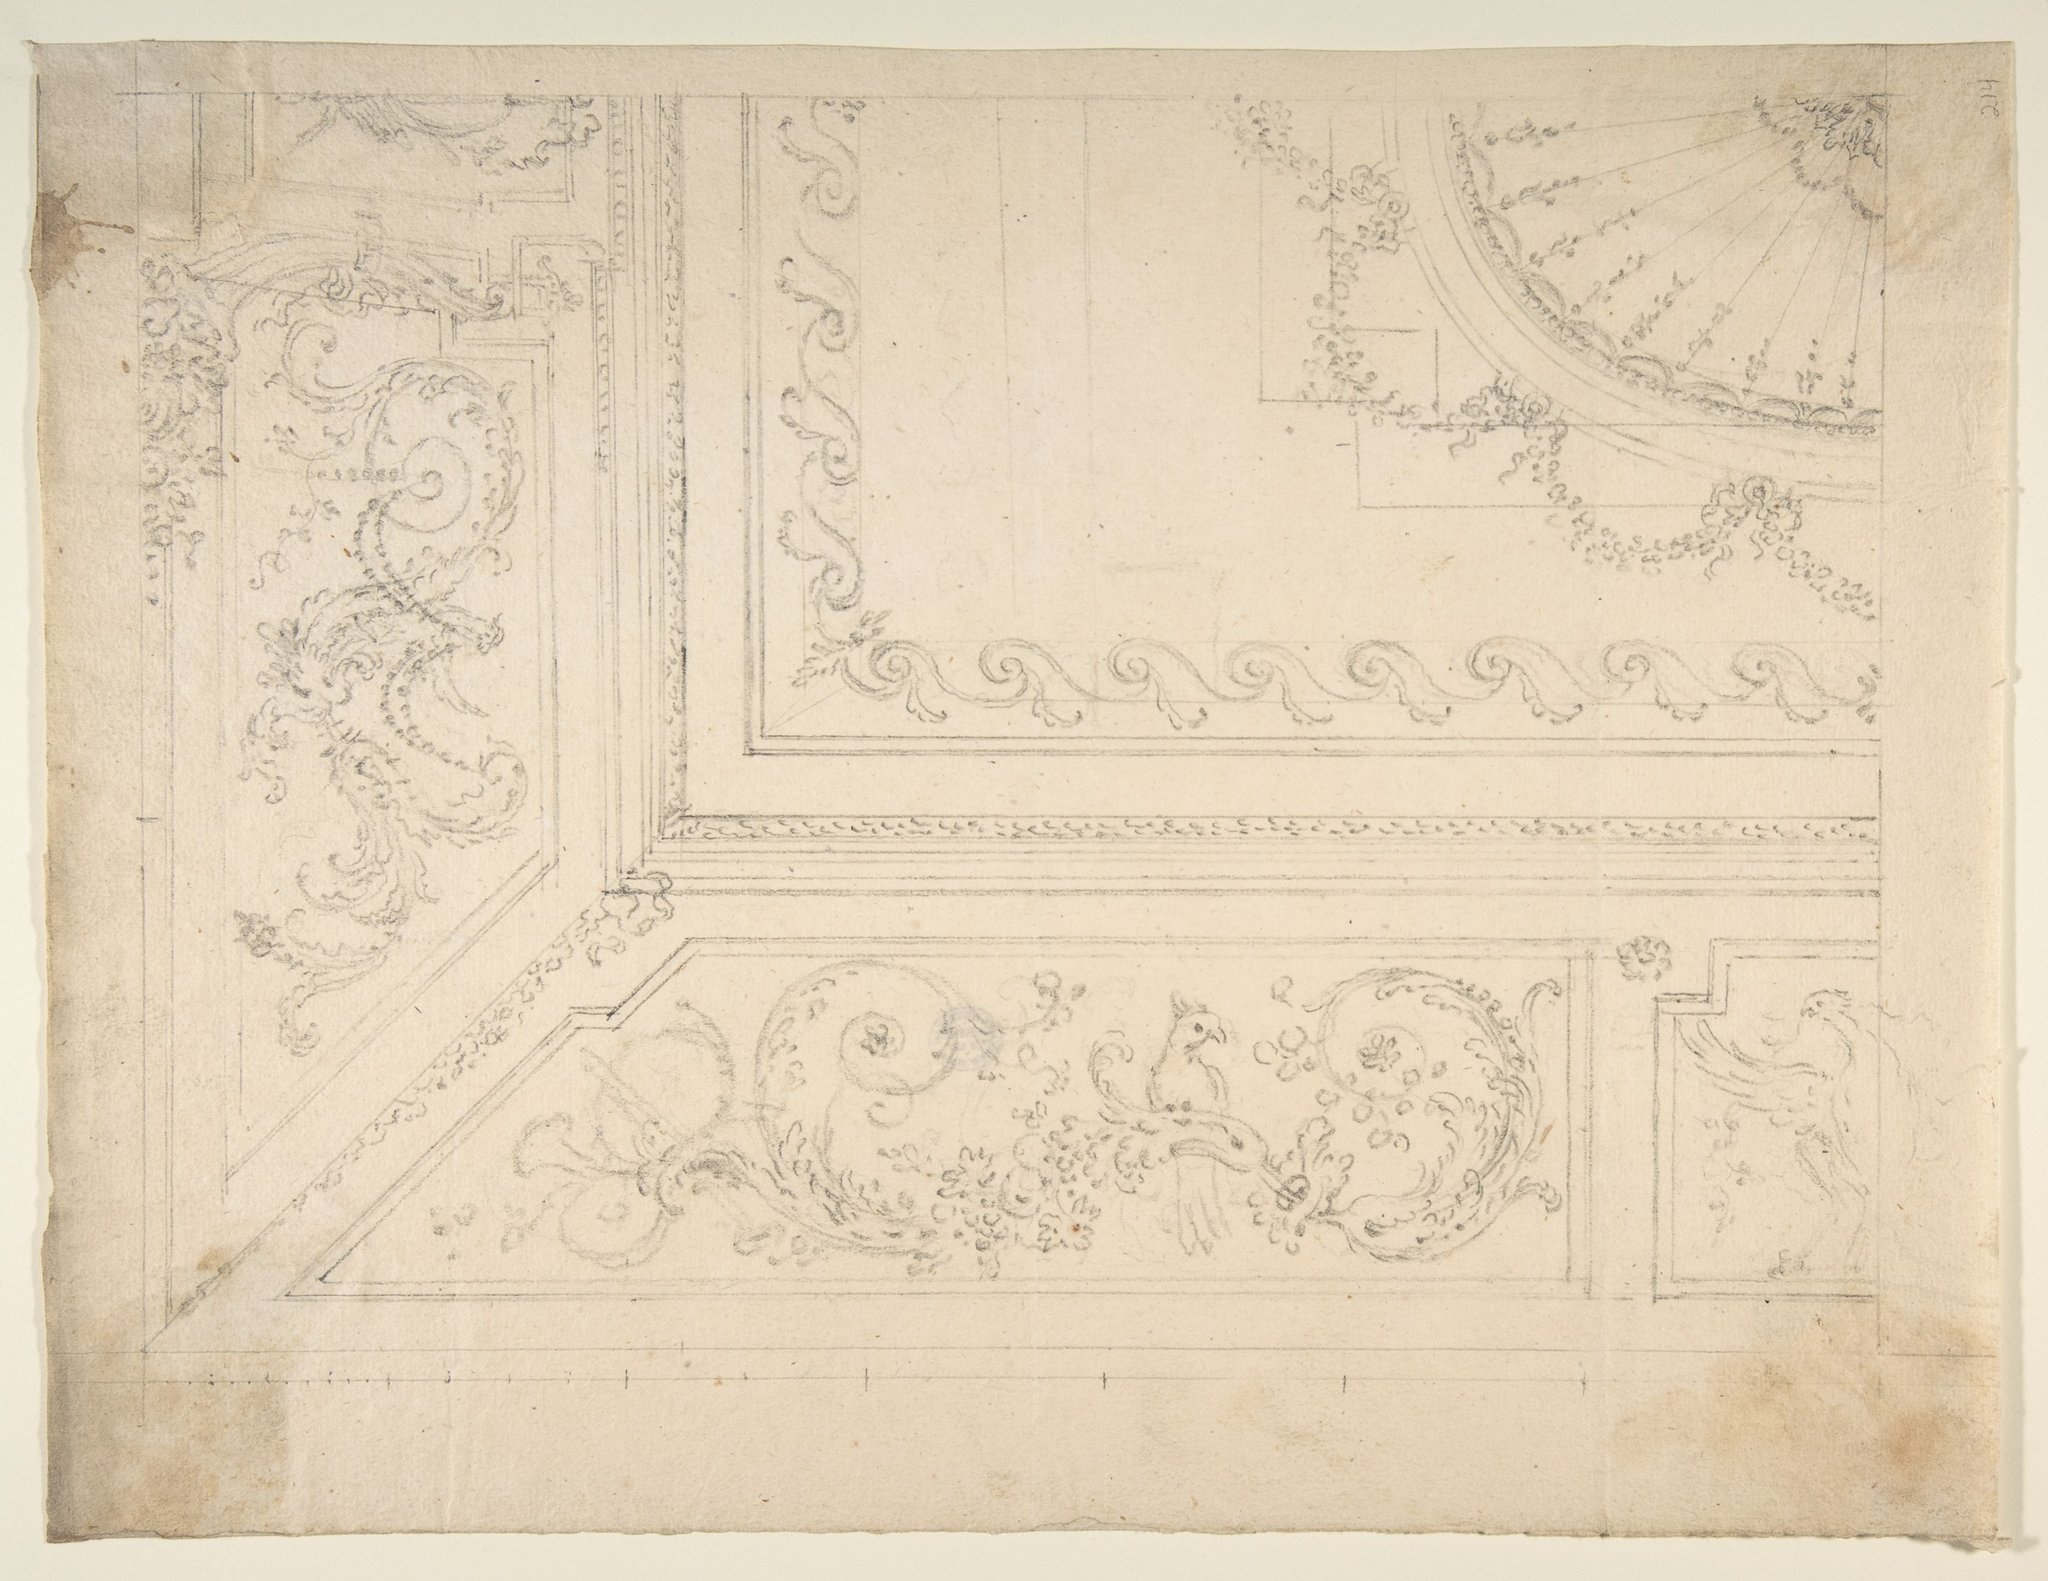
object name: drawing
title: Design for Ceiling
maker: leonardo marini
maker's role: artist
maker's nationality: italian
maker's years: 1730-1797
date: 1701-1800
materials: graphite, drawing material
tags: birds,ornament